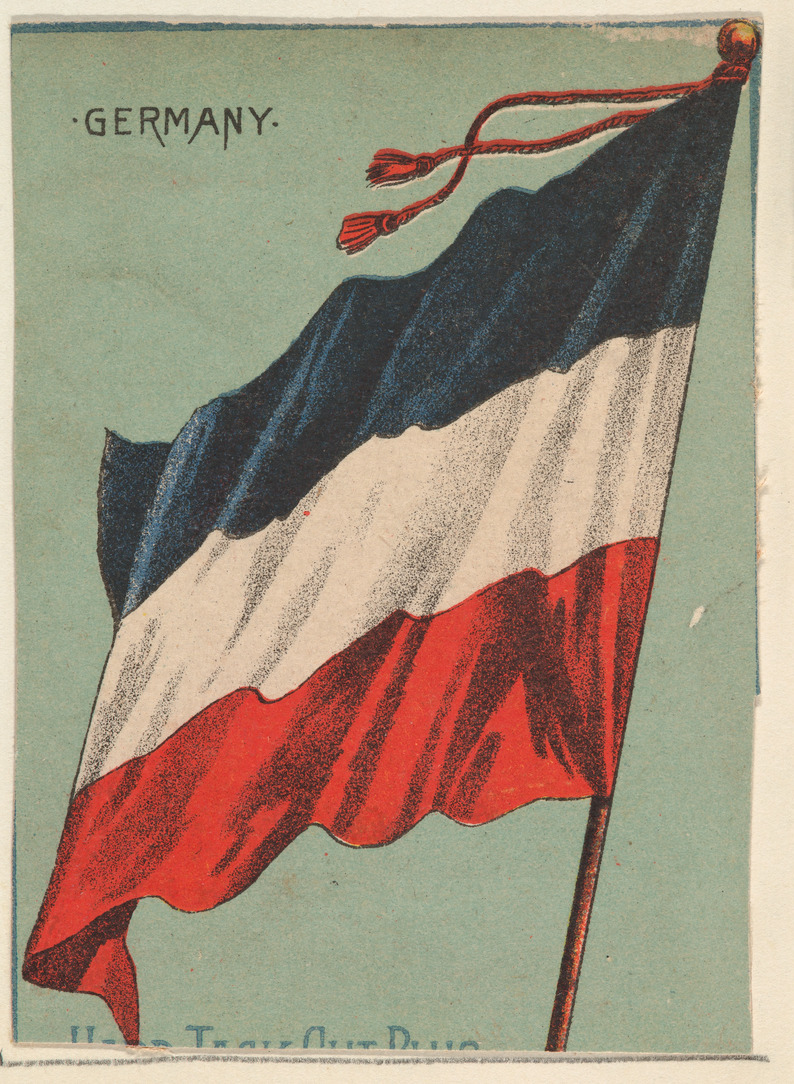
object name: print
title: Germany, from the National Flags series (N195) issued by Wm. S. Kimball & Co.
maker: william s. kimball & company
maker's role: publisher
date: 1891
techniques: color lithograph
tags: flags